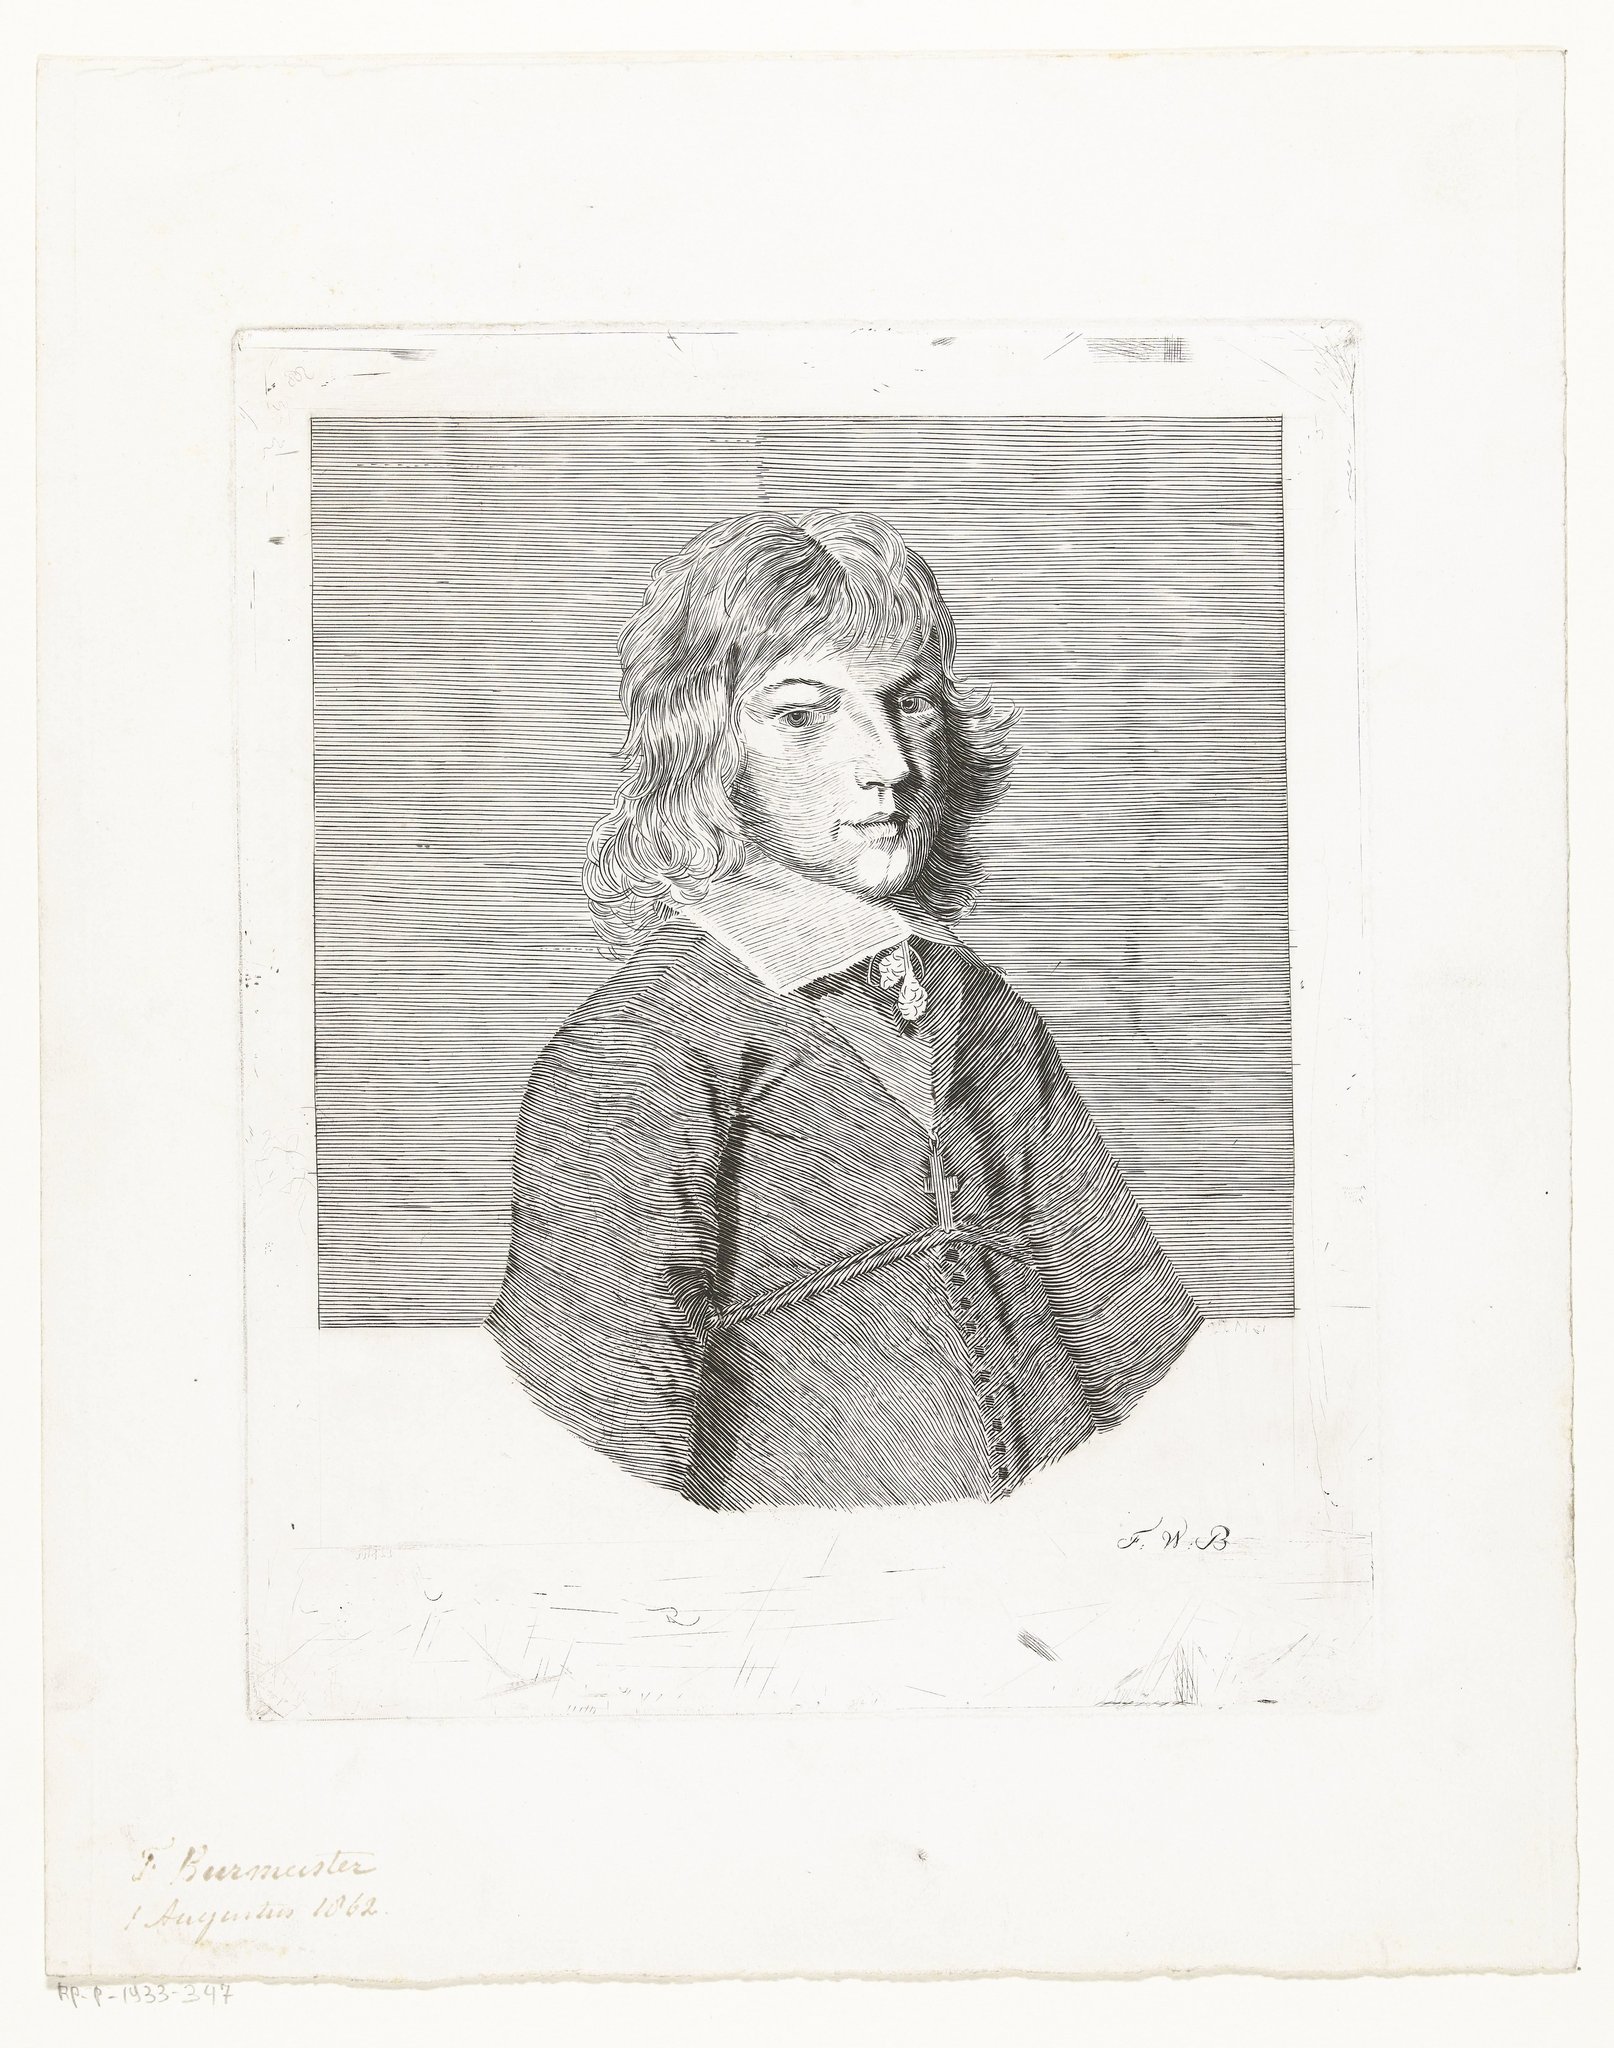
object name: print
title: Portret van een jongeling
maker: friedrich wilhelm burmeister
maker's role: print maker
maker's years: 1845-1933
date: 1855-1915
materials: paper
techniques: engraving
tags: the (nude) human figure; 'corpo humano' (ripa) (+ young male (human being))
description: Portret van een jongeling tussen de 14 en de 16 jaar oud. Buste naar rechts. De jongen draagt een zwarte jas en een medaillon met een kruis.